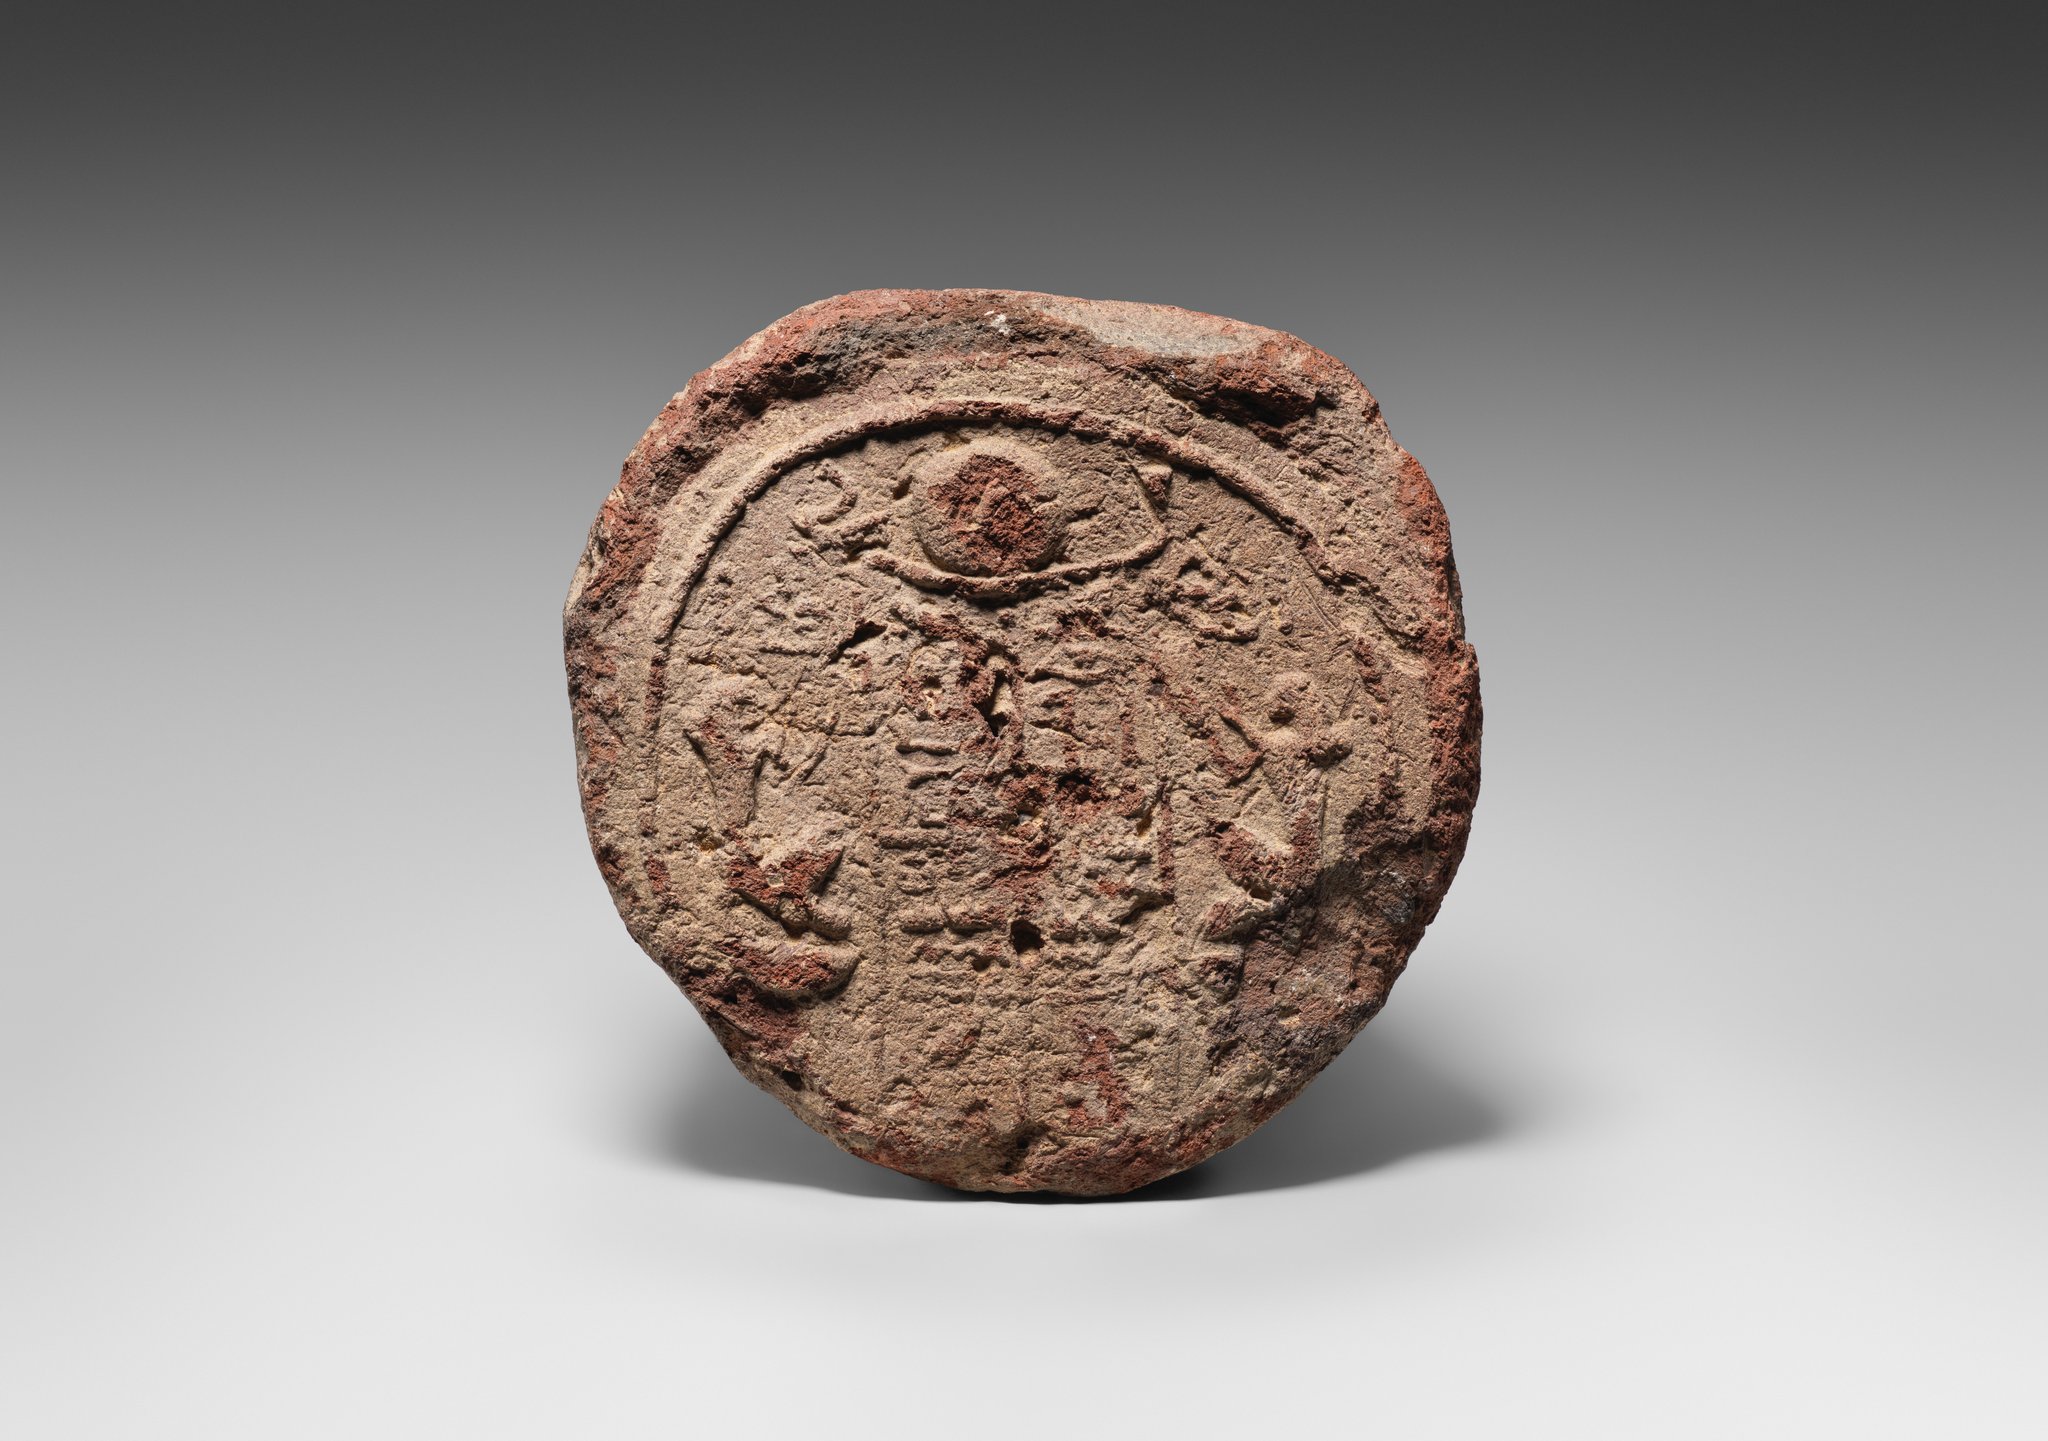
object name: cone, circular impression, montuemhat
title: Funerary Cone of Montuemhat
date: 724-525 BCE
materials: pottery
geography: egypt